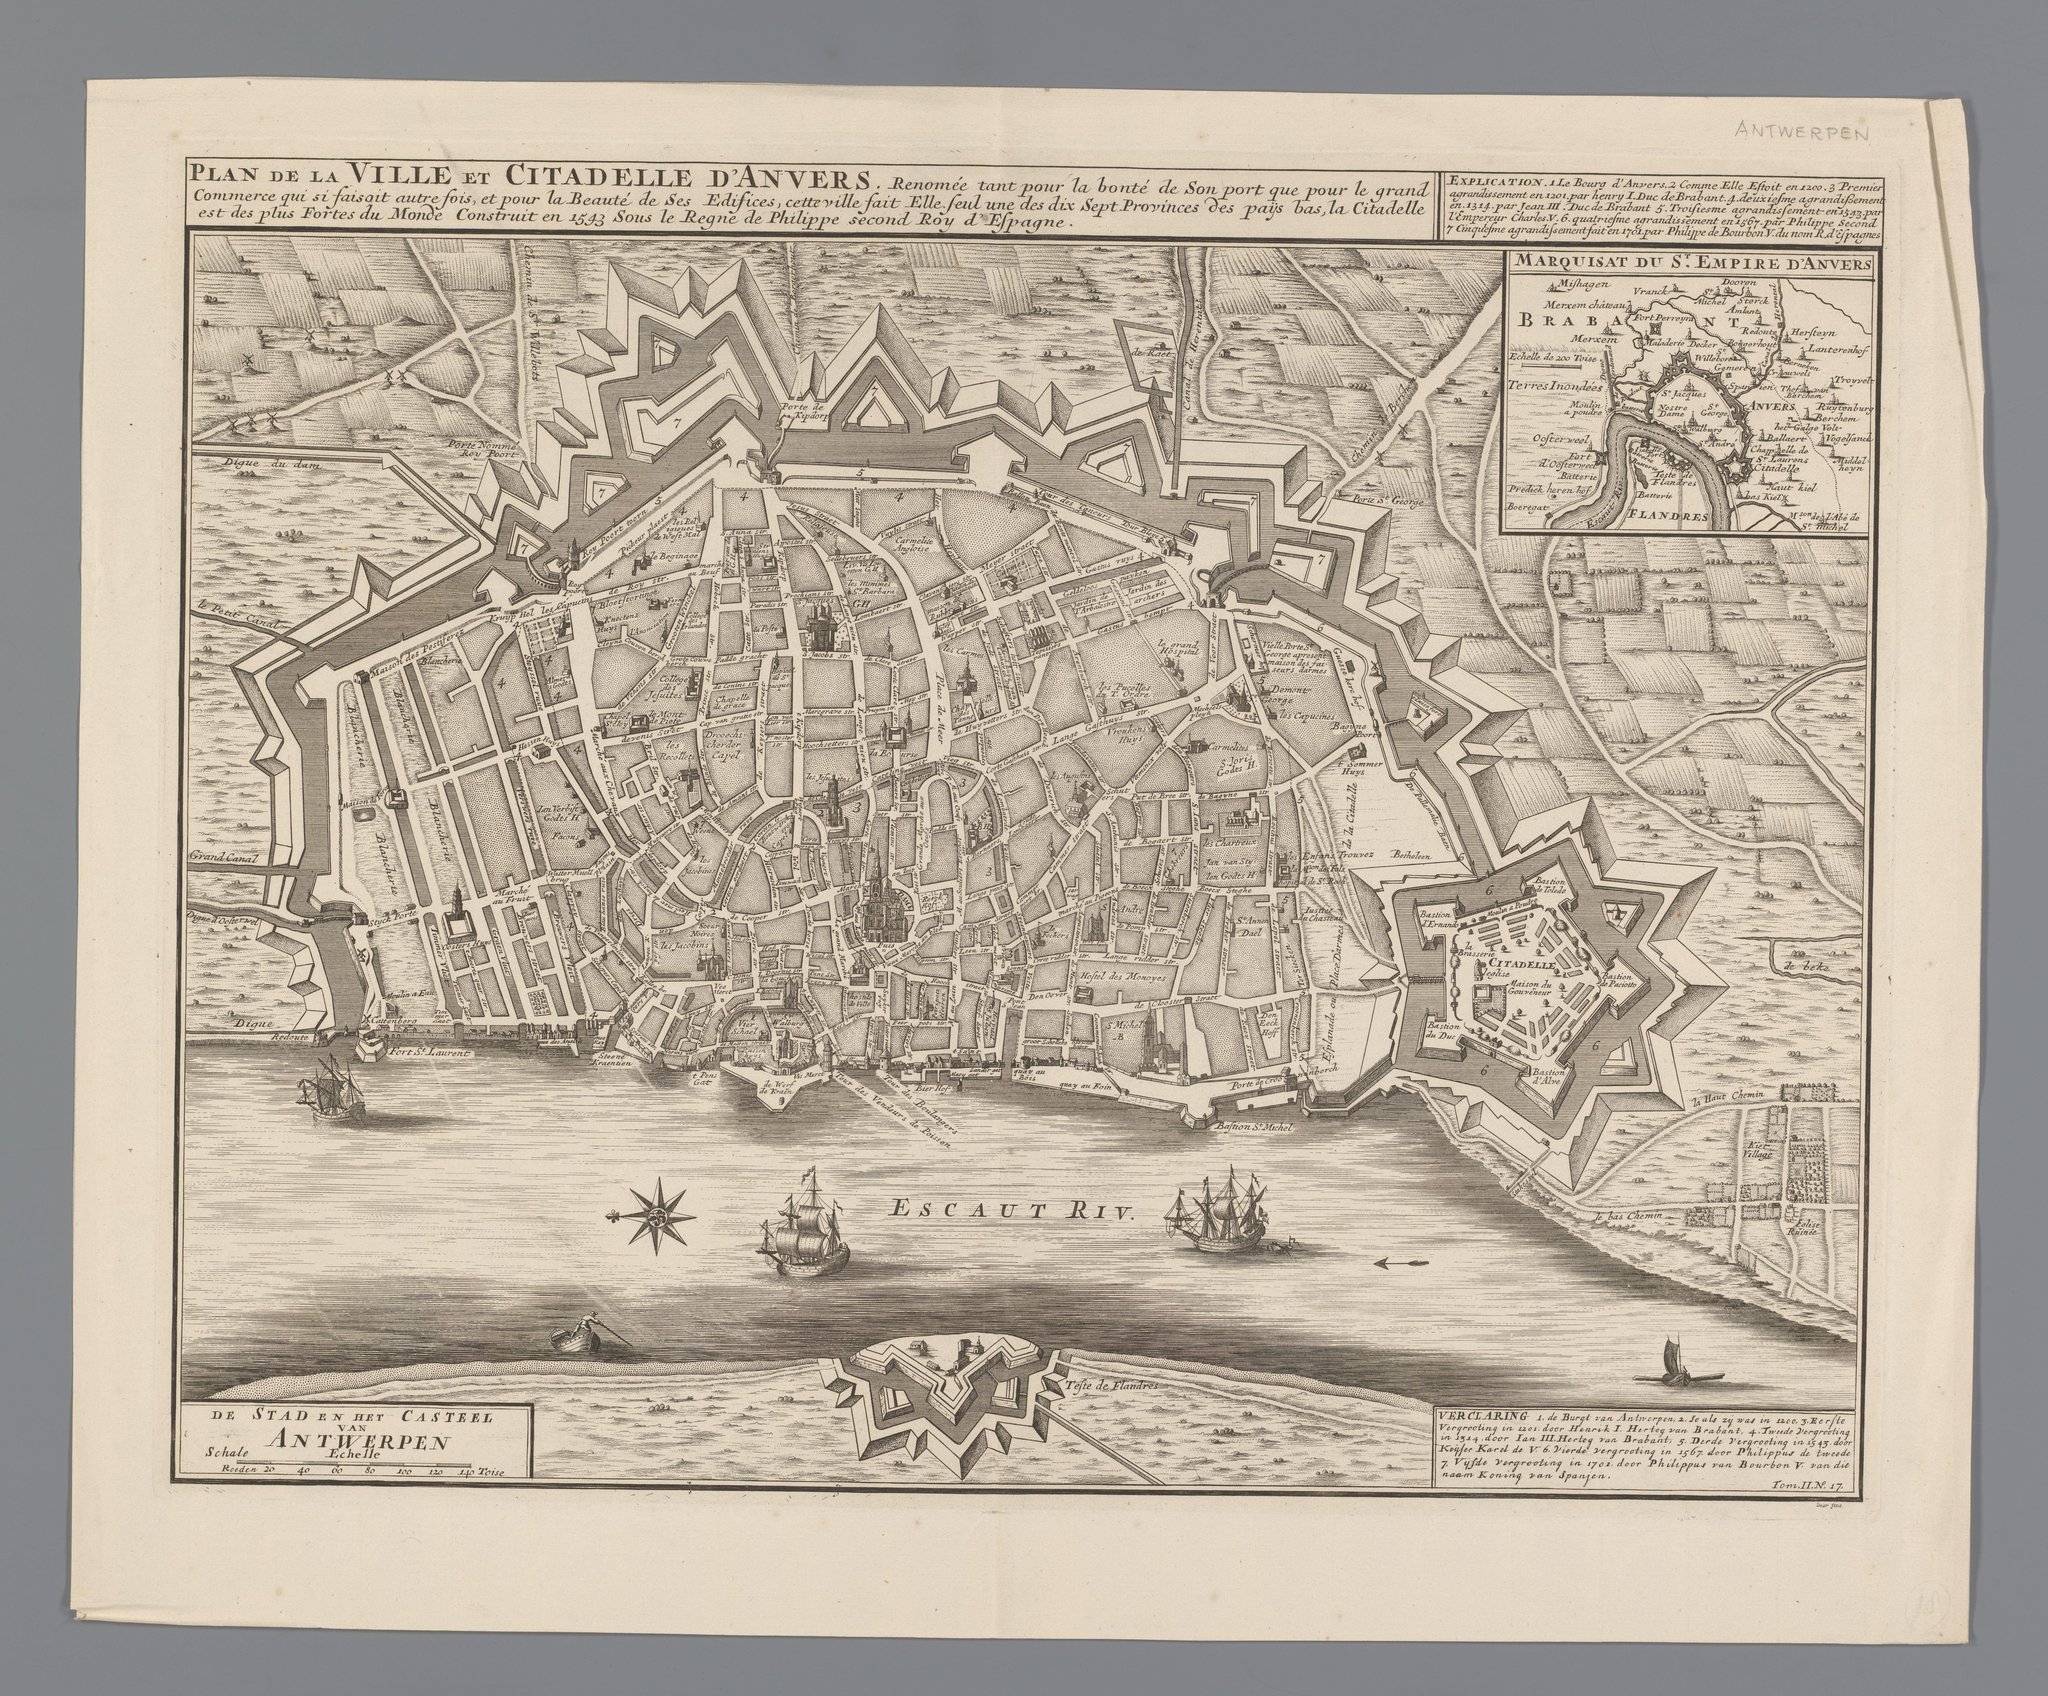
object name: area plan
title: Plan de la Ville et Citadelle d'Anvers (...)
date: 1650-1719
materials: paper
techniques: etching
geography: amsterdam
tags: maps of cities, antwerp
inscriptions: collector's mark: Lugt 2760, collector's mark: Lugt 2166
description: Plattegrond van Antwerpen en de Citadel. Met ingezette kaart van het markizaat Antwerpen.